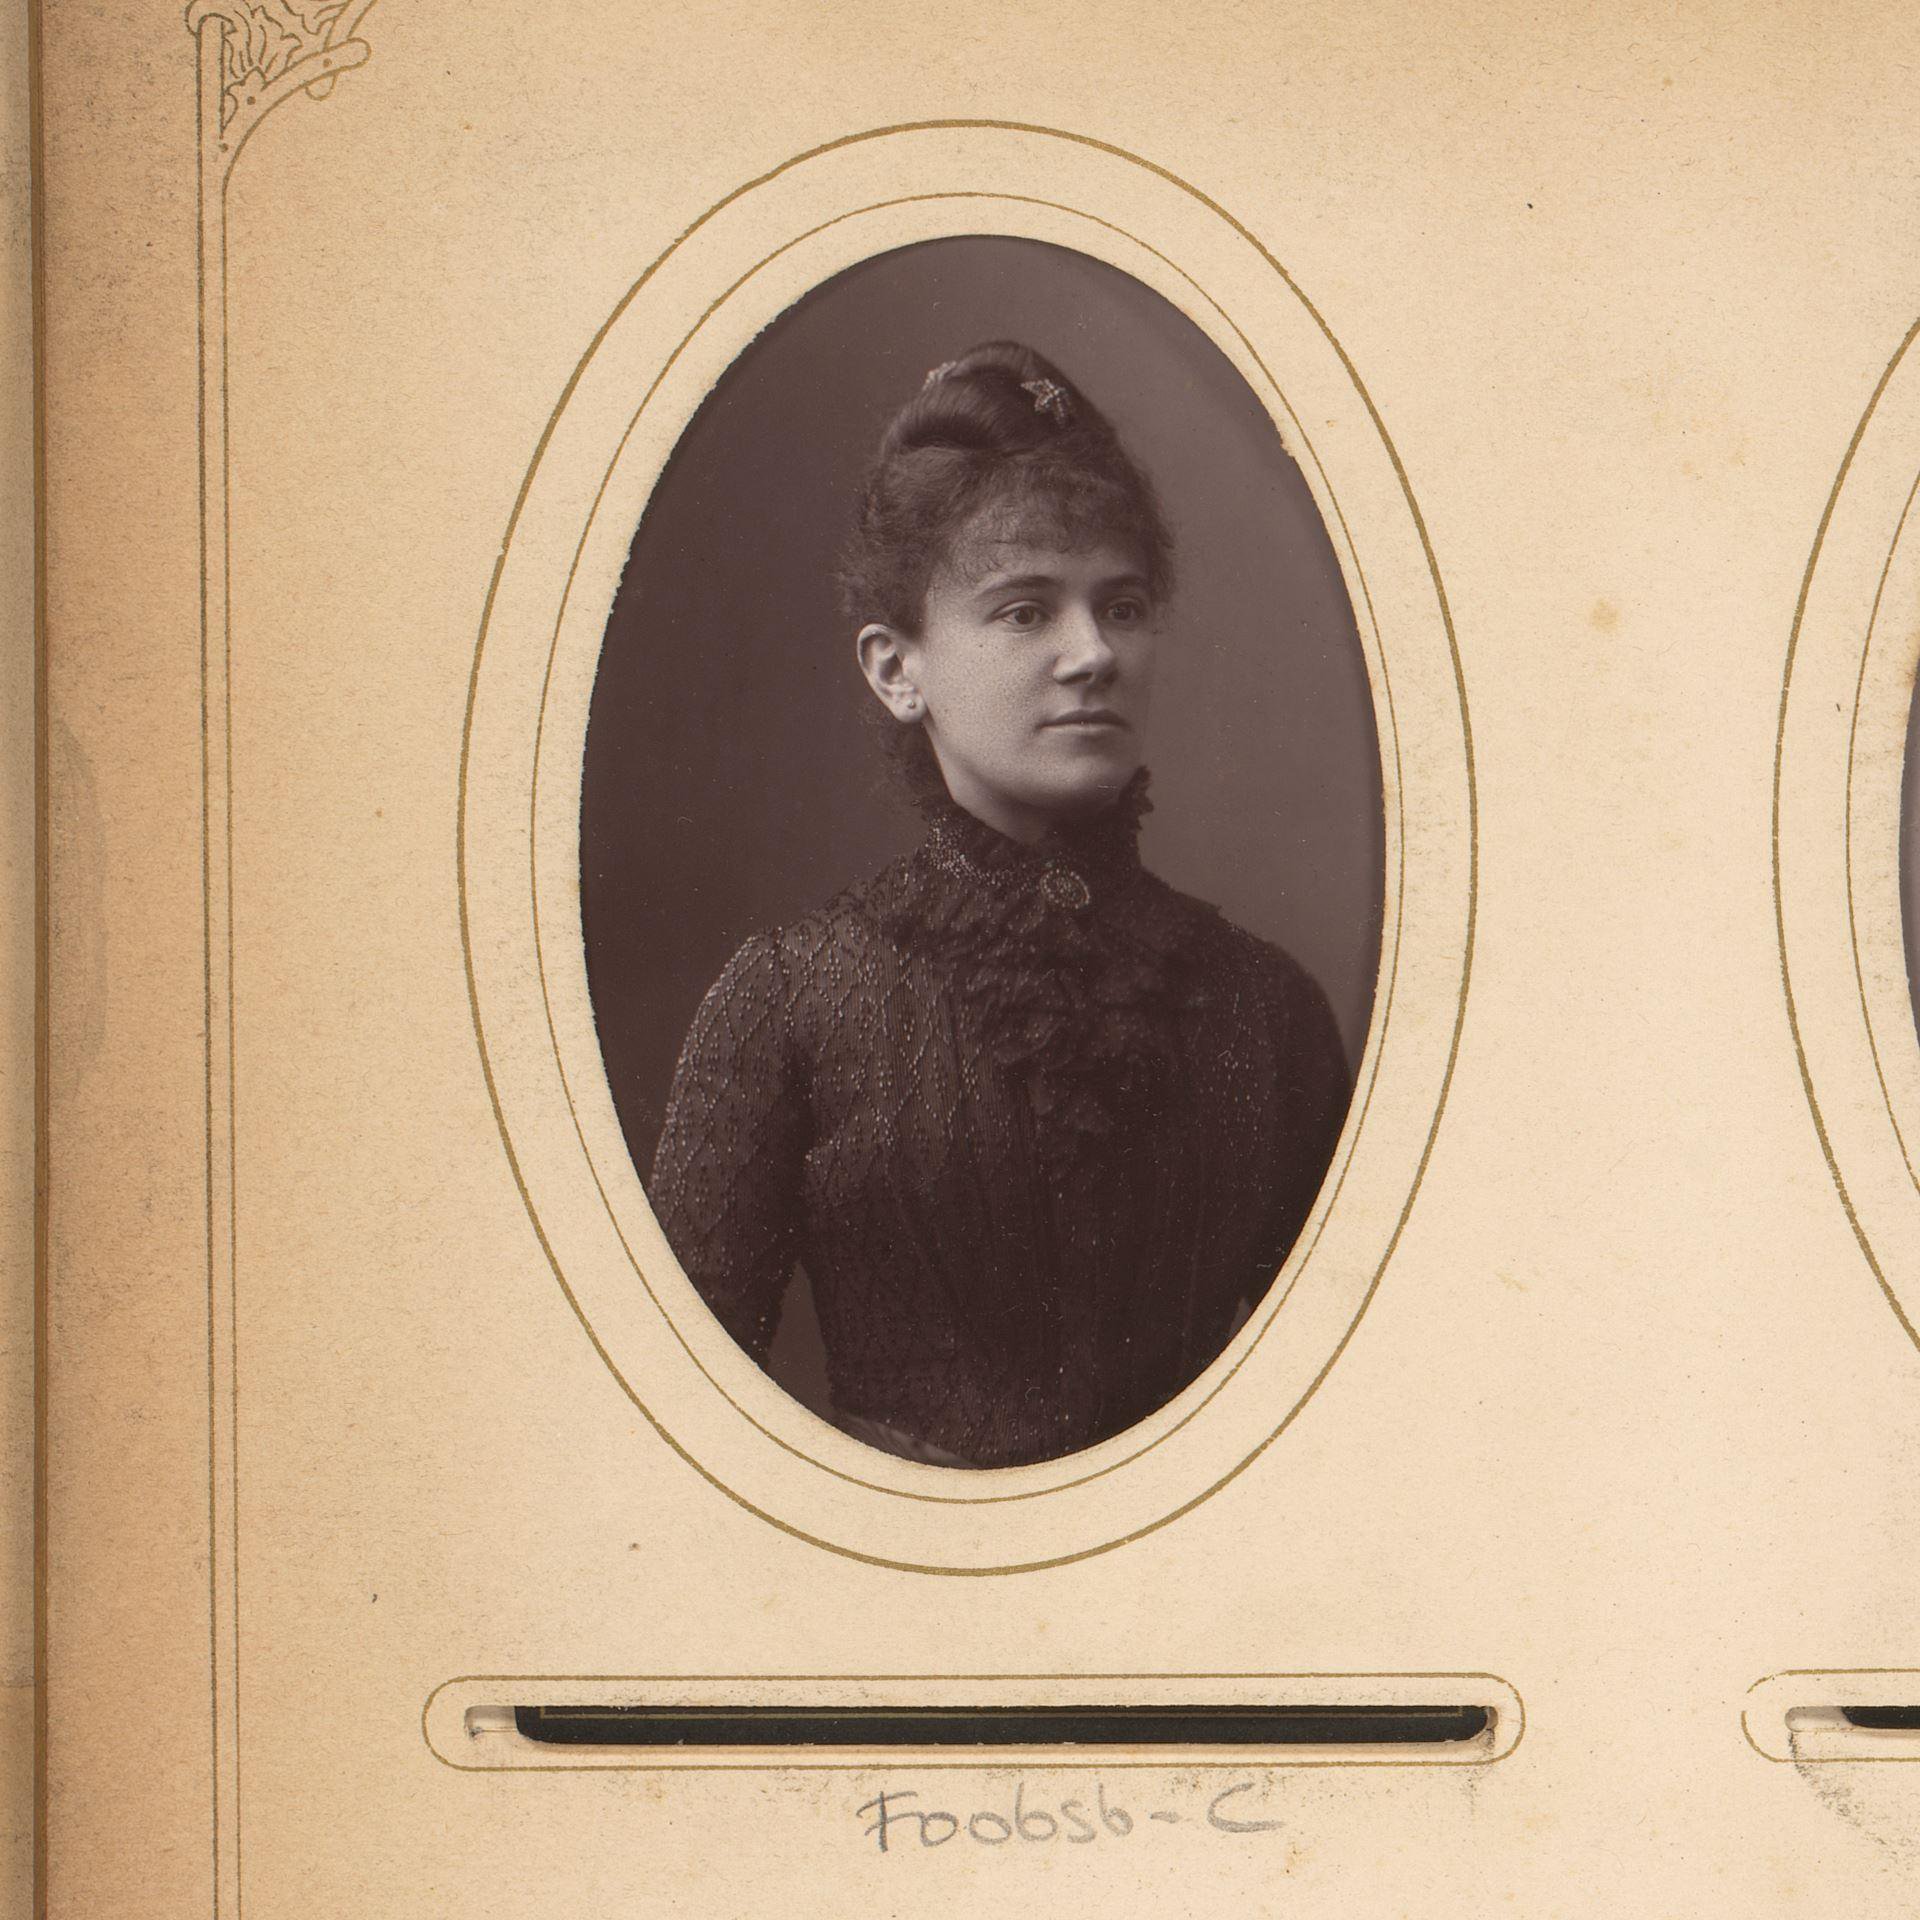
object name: carte de visite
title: Portret van een vrouw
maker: edmond sacré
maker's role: fotograaf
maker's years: 1851-1921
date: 1890-1920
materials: cardboard, paper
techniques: carbon print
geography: ghent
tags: historical persons - bb - woman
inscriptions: inscription: ‘Photographie Artistique et Industrielle/ Edmond Sacré/ Rue des douze Chambres 15/ Gand/ Récompenses à 10 Expositions./ Les Clichés sont conservés.’